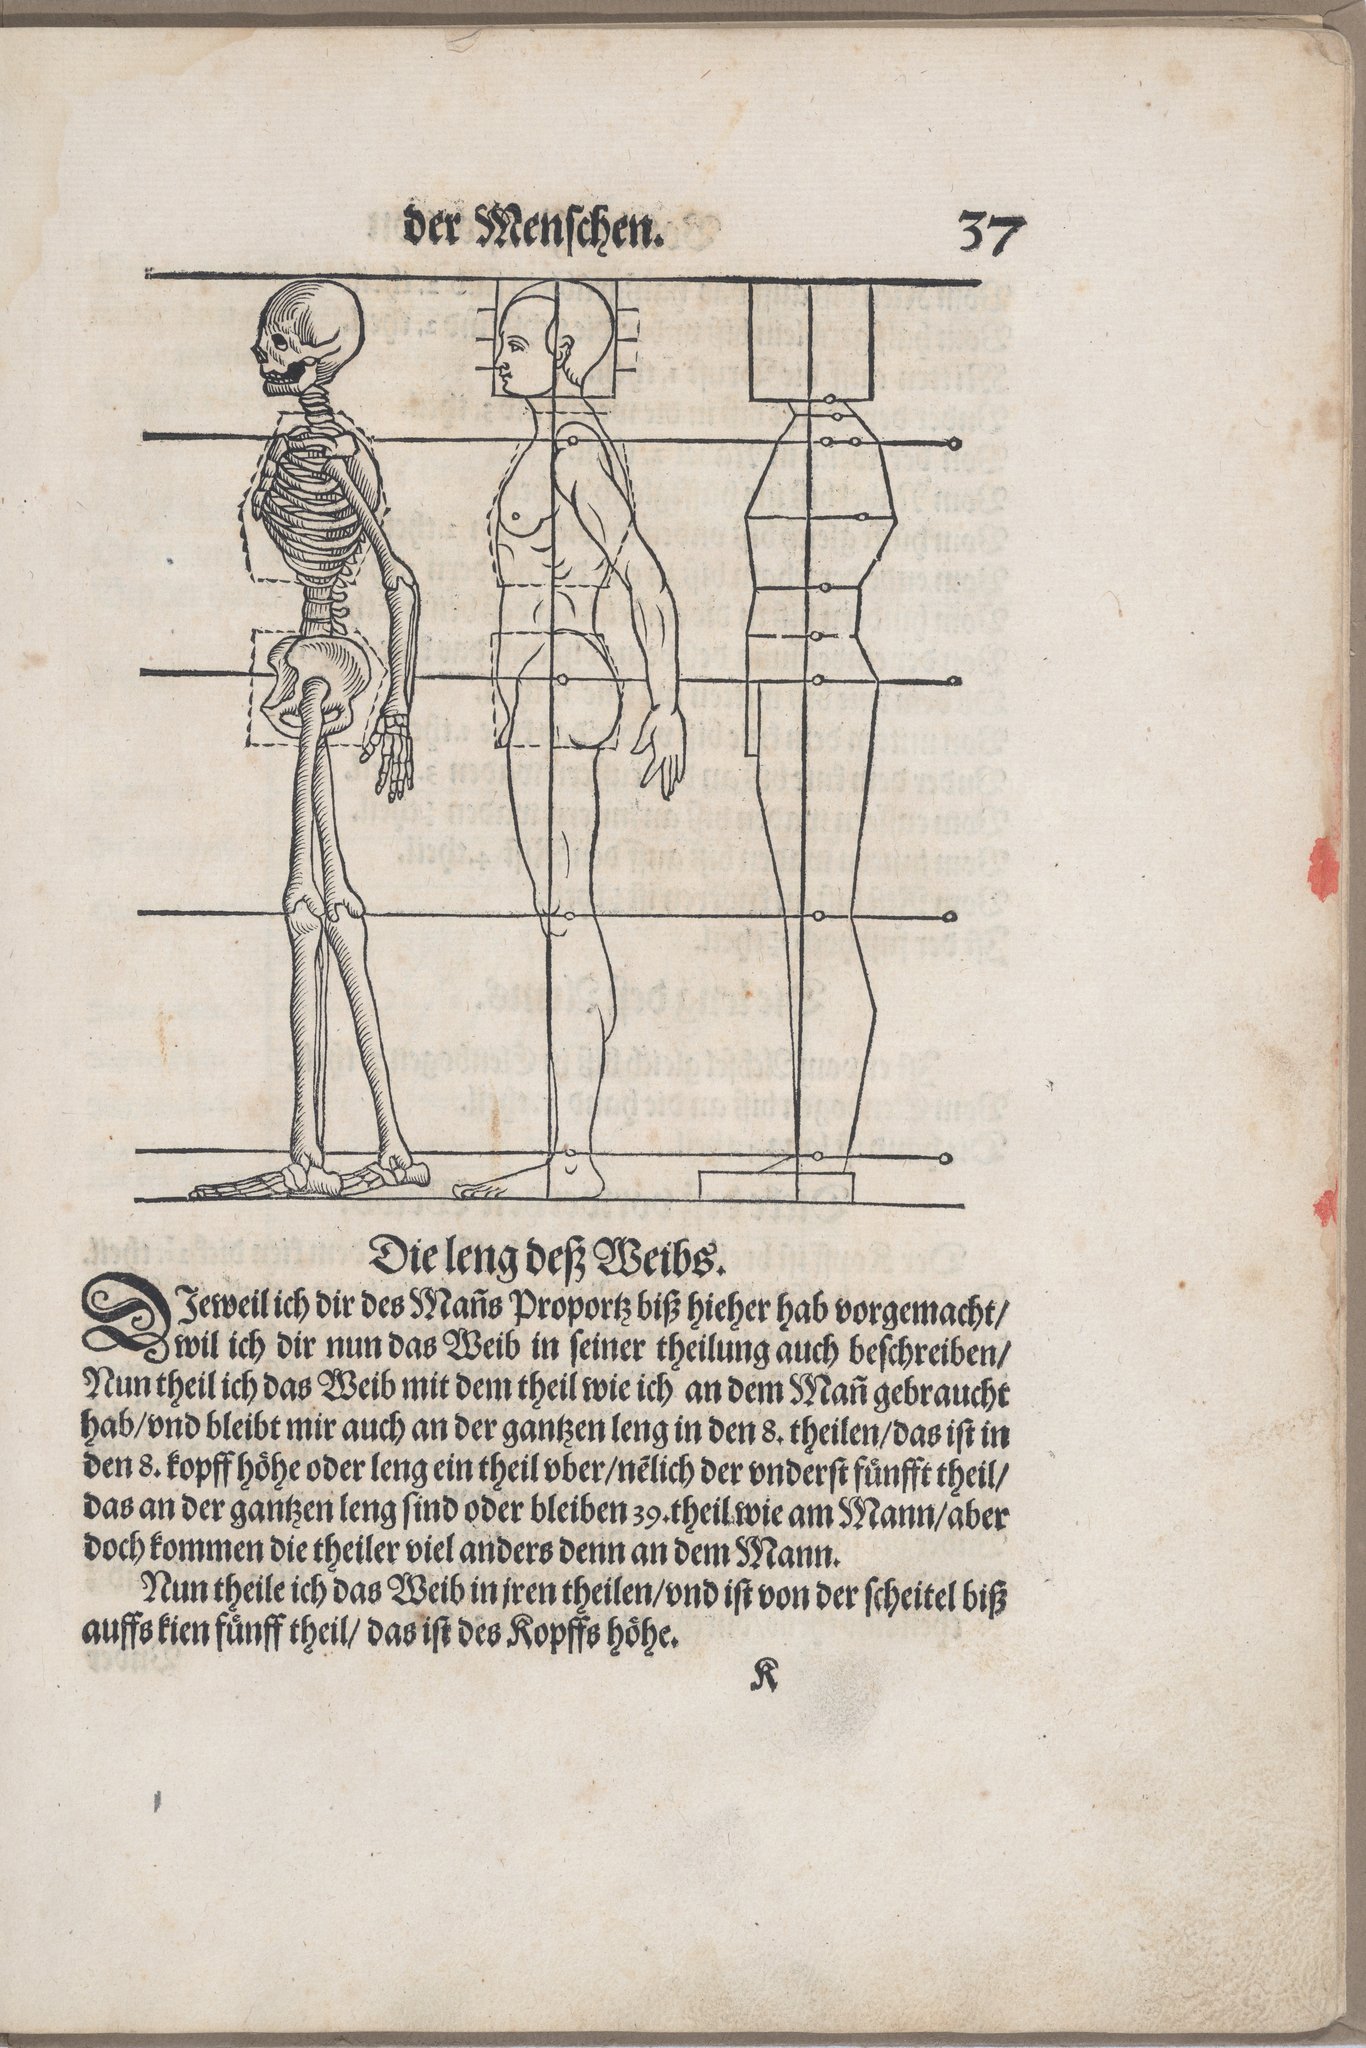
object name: book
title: Des Circkels unnd Richtscheyts, auch der Perspectiva und Proportion der Menschen und Rosse, kurtze, doch gründtliche underweisung deß rechten gebrauchs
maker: heinrich lautensack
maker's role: artist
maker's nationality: german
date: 1564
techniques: woodcut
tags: skeletons